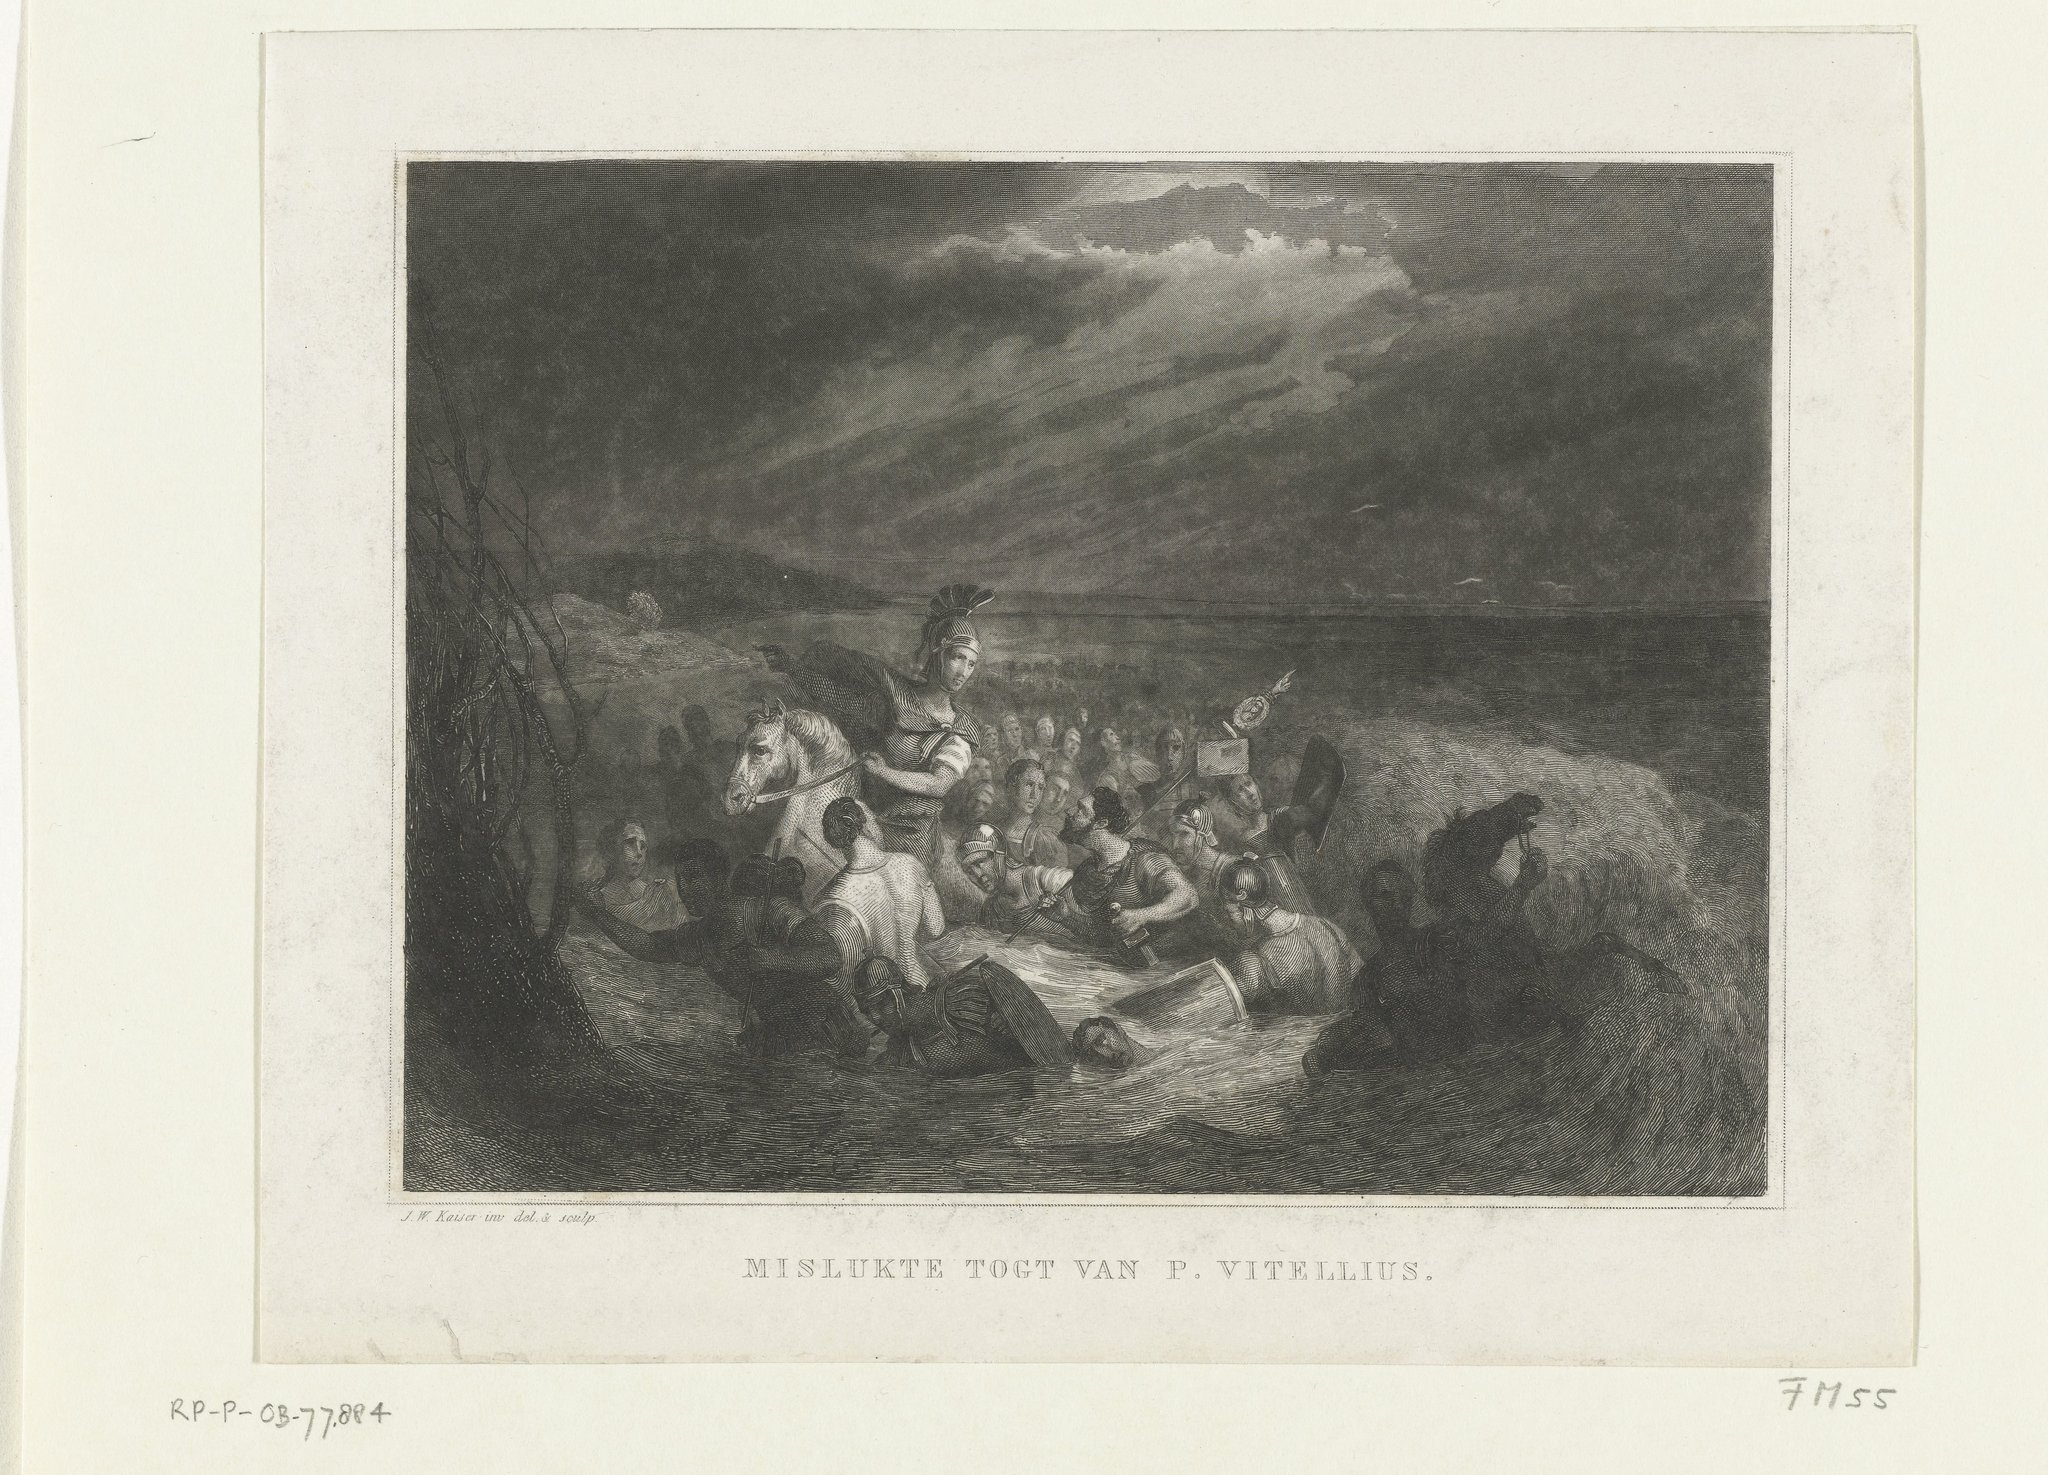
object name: history print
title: Mislukte zeetocht van Vitellius naar het noorden van Germanië, 16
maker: johann wilhelm kaiser (i)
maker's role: draughtsman, print maker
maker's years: 1813-1900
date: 1838-1840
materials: paper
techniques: engraving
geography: netherlands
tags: extinct, 'historical' peoples (with name), netherlands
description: Troepen onder leiding van de Romeinse veldheer P. Vitellius worden in het jaar 16 tijdens een tocht naar het noorden van Germanië verzwolgen door het water.